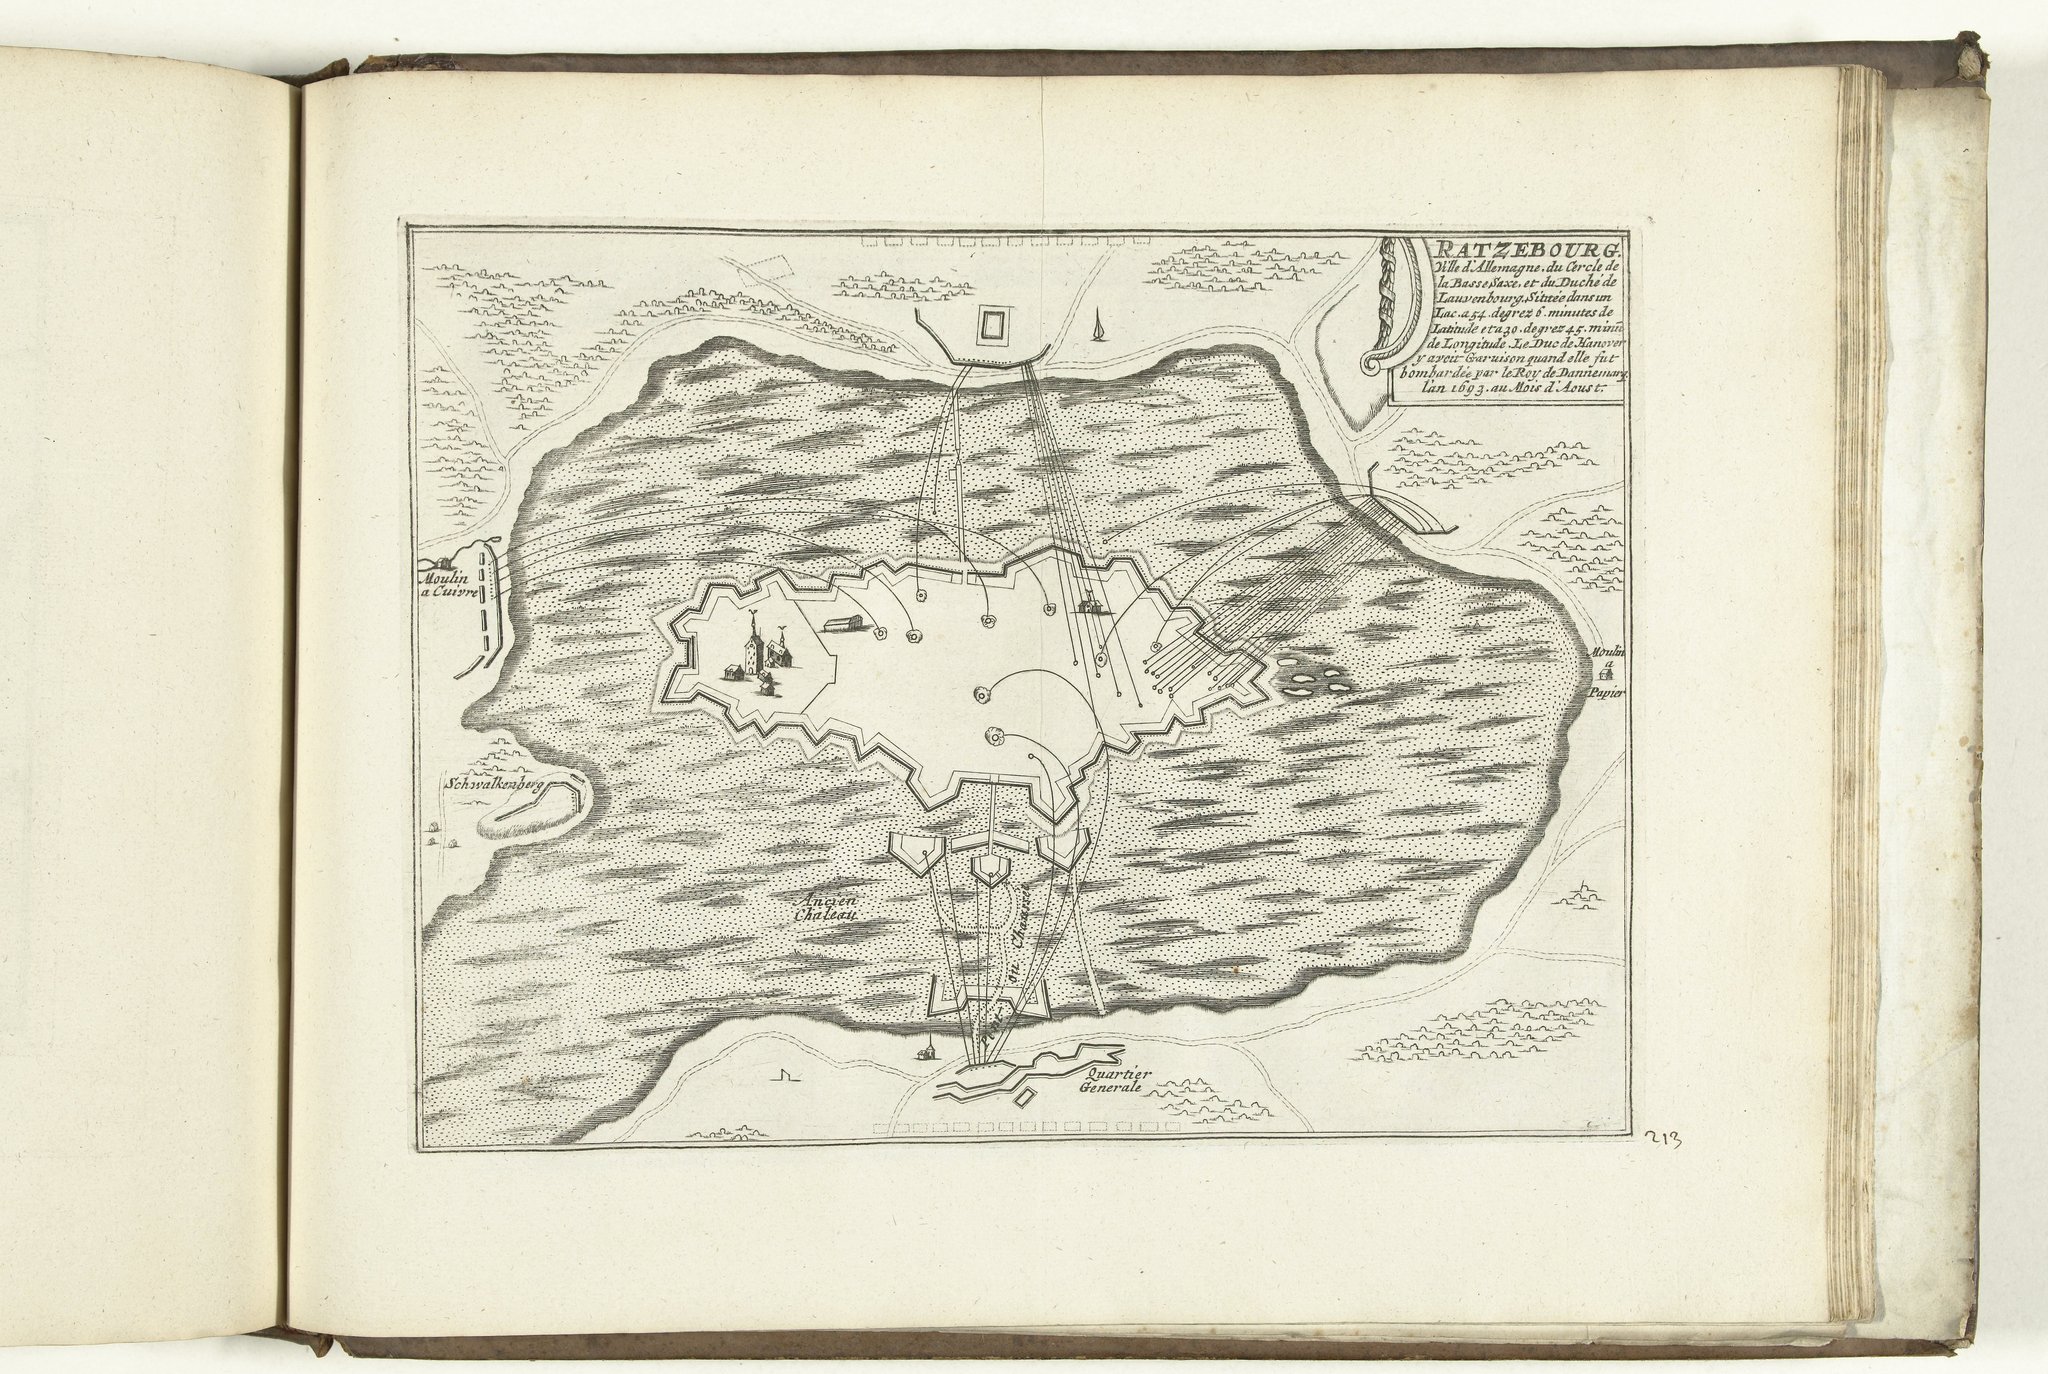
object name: map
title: Ratzebourg, Ville d'Allemagne, du Cercle de la Basse (...) bombardée par le Roy de Dannemarq. l'an 1693. au Mois d'Aoust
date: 1726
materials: paper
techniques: engraving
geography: leiden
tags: copenhagen (city), fortress, bombardment ~ siege, maps of cities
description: Bombardement van de stad Ratzeburg in Sleeswijk-Holstein door het Deense leger onder Christiaan V, van augustus 1693 tot april 1694. Plaat nr. 213 in deel IX van het prentwerk: Les Forces de l'Europe, Asie, Afrique et Amerique ... Comme aussi les Cartes des Côtes de France et d'Espagne uit 1726, dit eerste deel met 238 met de hand genummerde platen van vermaarde sterke steden en vestingen in het kader van de Spaanse Successieoorlog 1701-1713. Voor het merendeel zijn deze platen gekopieerd naar de anonieme Franse platen van vermaarde sterke steden en vestingen: in Les forces de l'Europe en in: Le theatre de la guerre, dans les Pays-Bas, beide oorspronkelijk uitgegeven door Nicolas de Fer te Parijs (1693-1697) in het kader van de Negenjarige Oorlog. Titel en opschriften in het Frans.